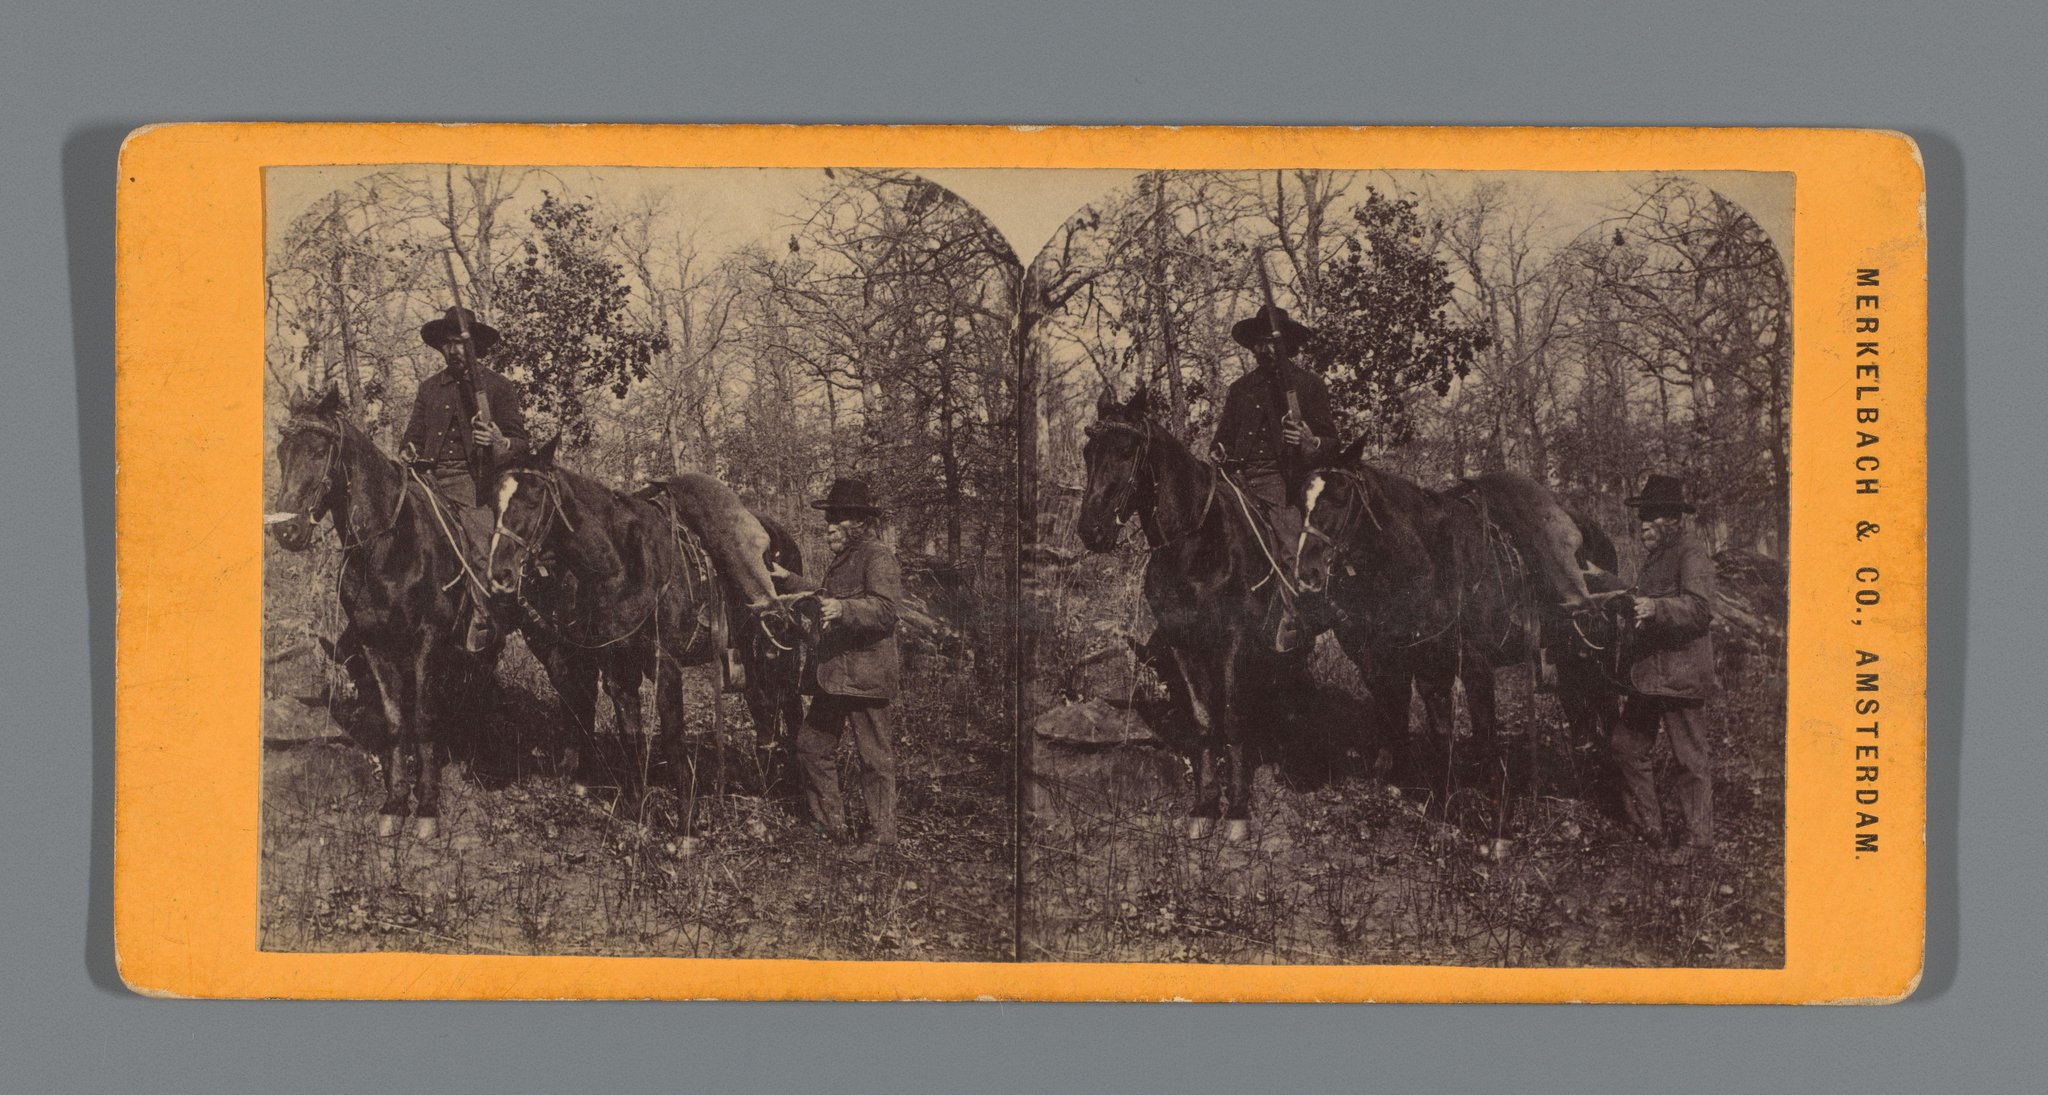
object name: stereograph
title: Aardrijkskundige Beeldengalerij, verzameld door M.J. Broekhuijsen, Hoofd eener school te Amsterdam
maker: martien johan broekhuijsen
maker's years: 1871-1956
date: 1905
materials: photographic support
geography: amsterdam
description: Onderdeel van een groep van 52 stereofoto's gebruikt in het lager onderwijs als aanvulling op schoolplaten. De gehele reeks bestond uit 274 nummers in 10 categorieën (A t/m K).